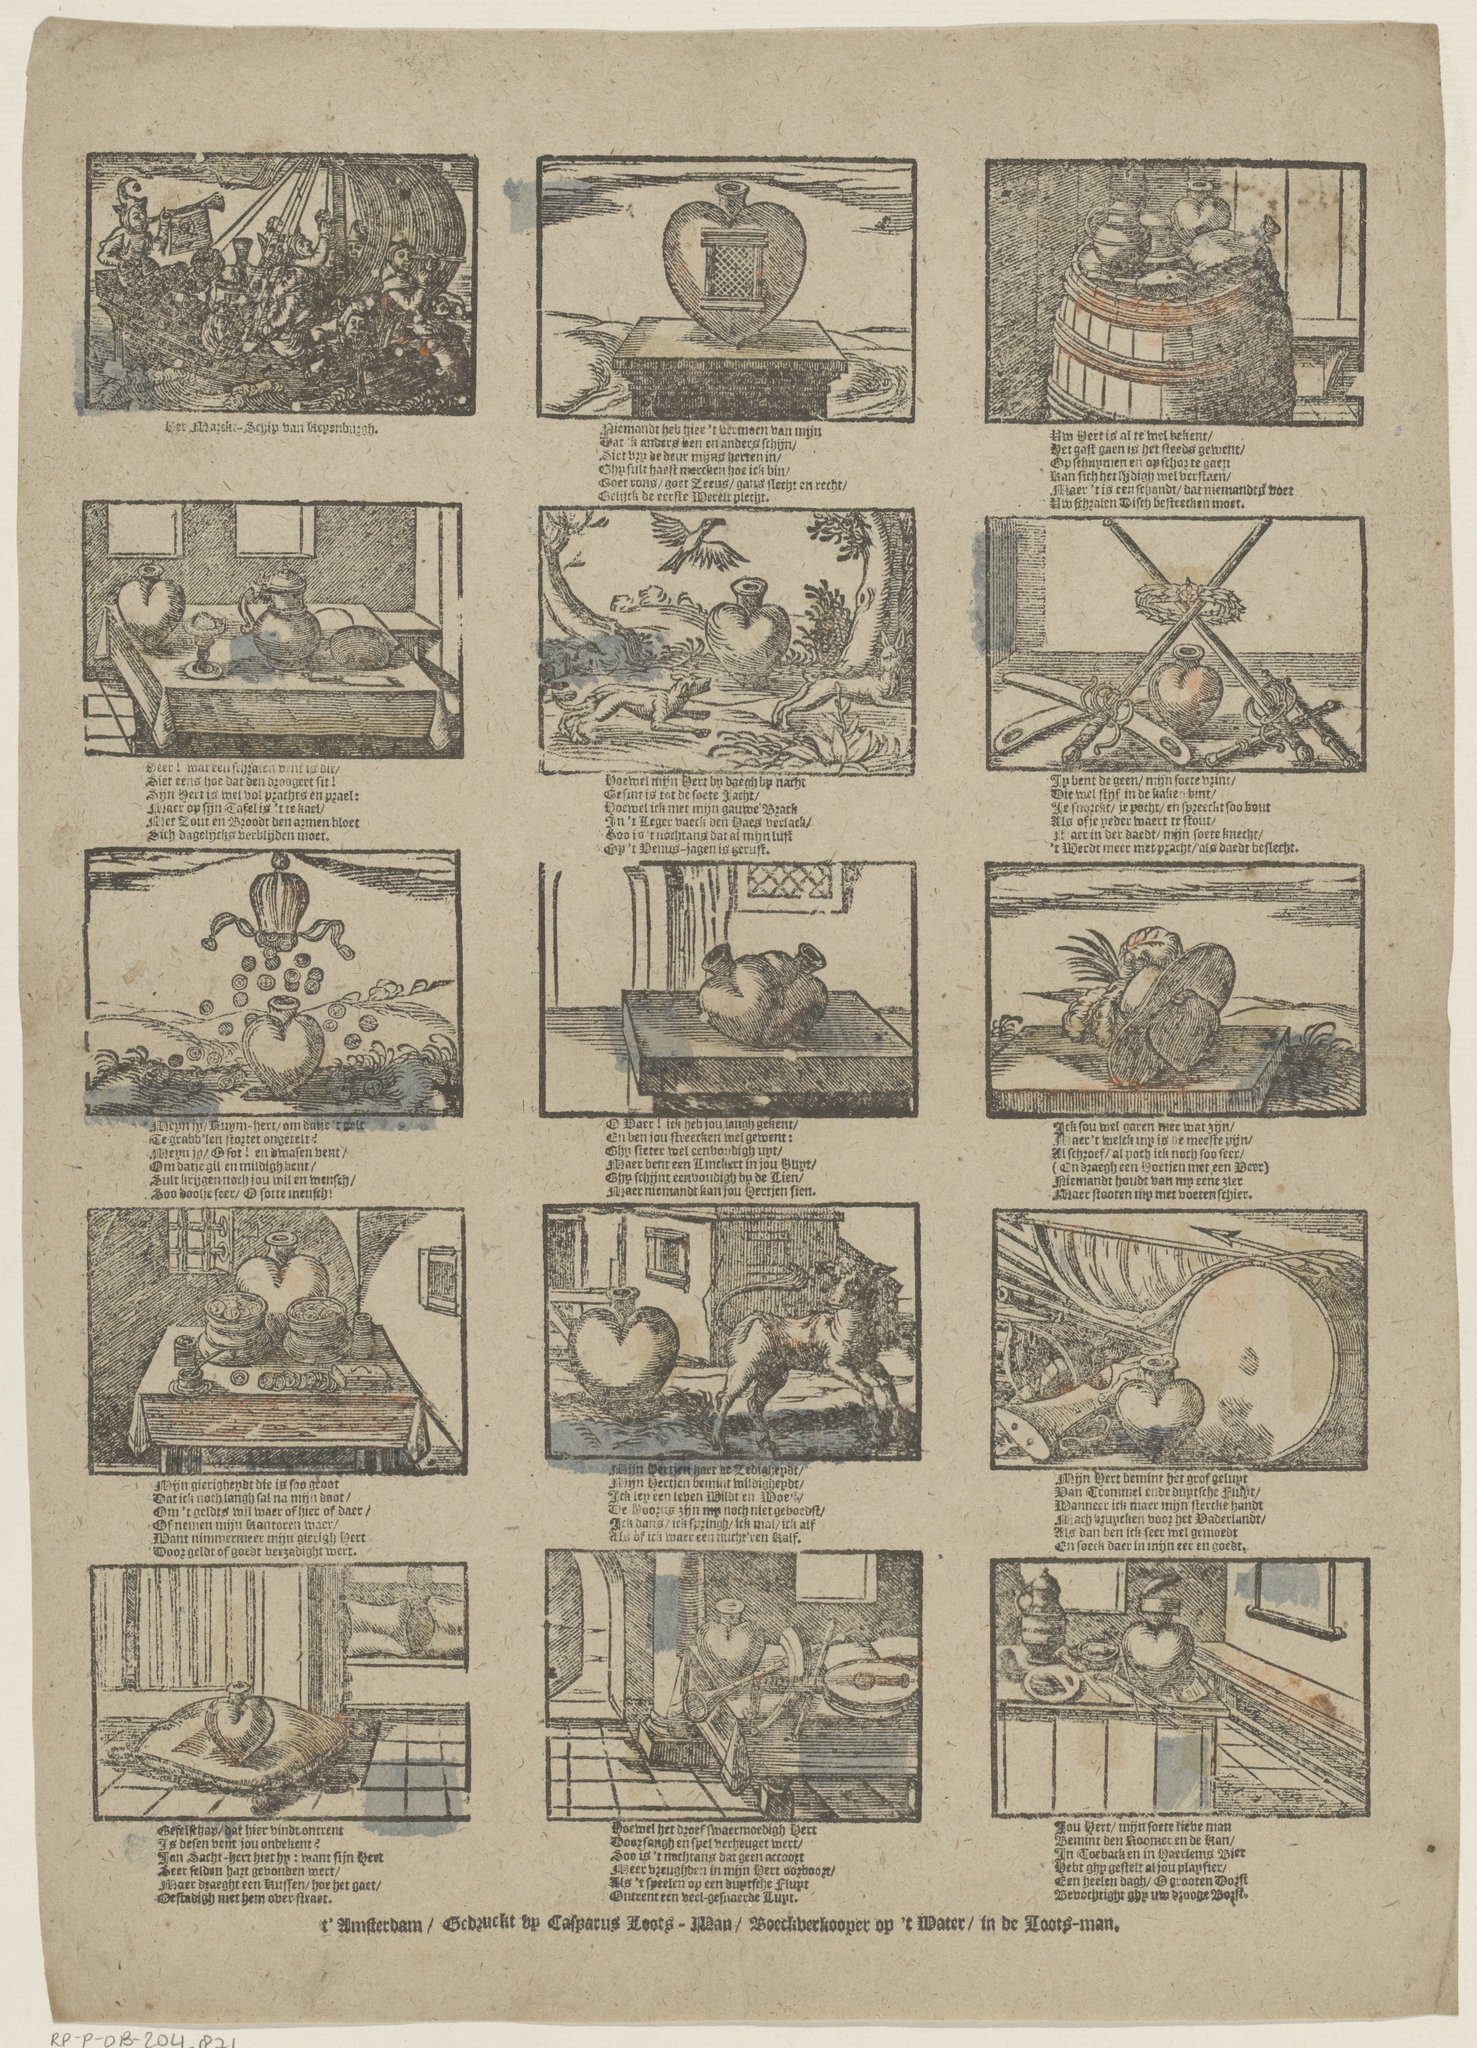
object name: popular print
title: Schip en allegorische voorstellingen van harten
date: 1689-1711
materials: paper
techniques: colour, letterpress printing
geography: amsterdam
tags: ships (in general)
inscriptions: collector's mark: Lugt 2760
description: Blad met 15 voorstellingen van het 'Marckt-schip van Keyenburgh' en allegorische voorstellingen van harten. Onder elke afbeelding een onderschrift.